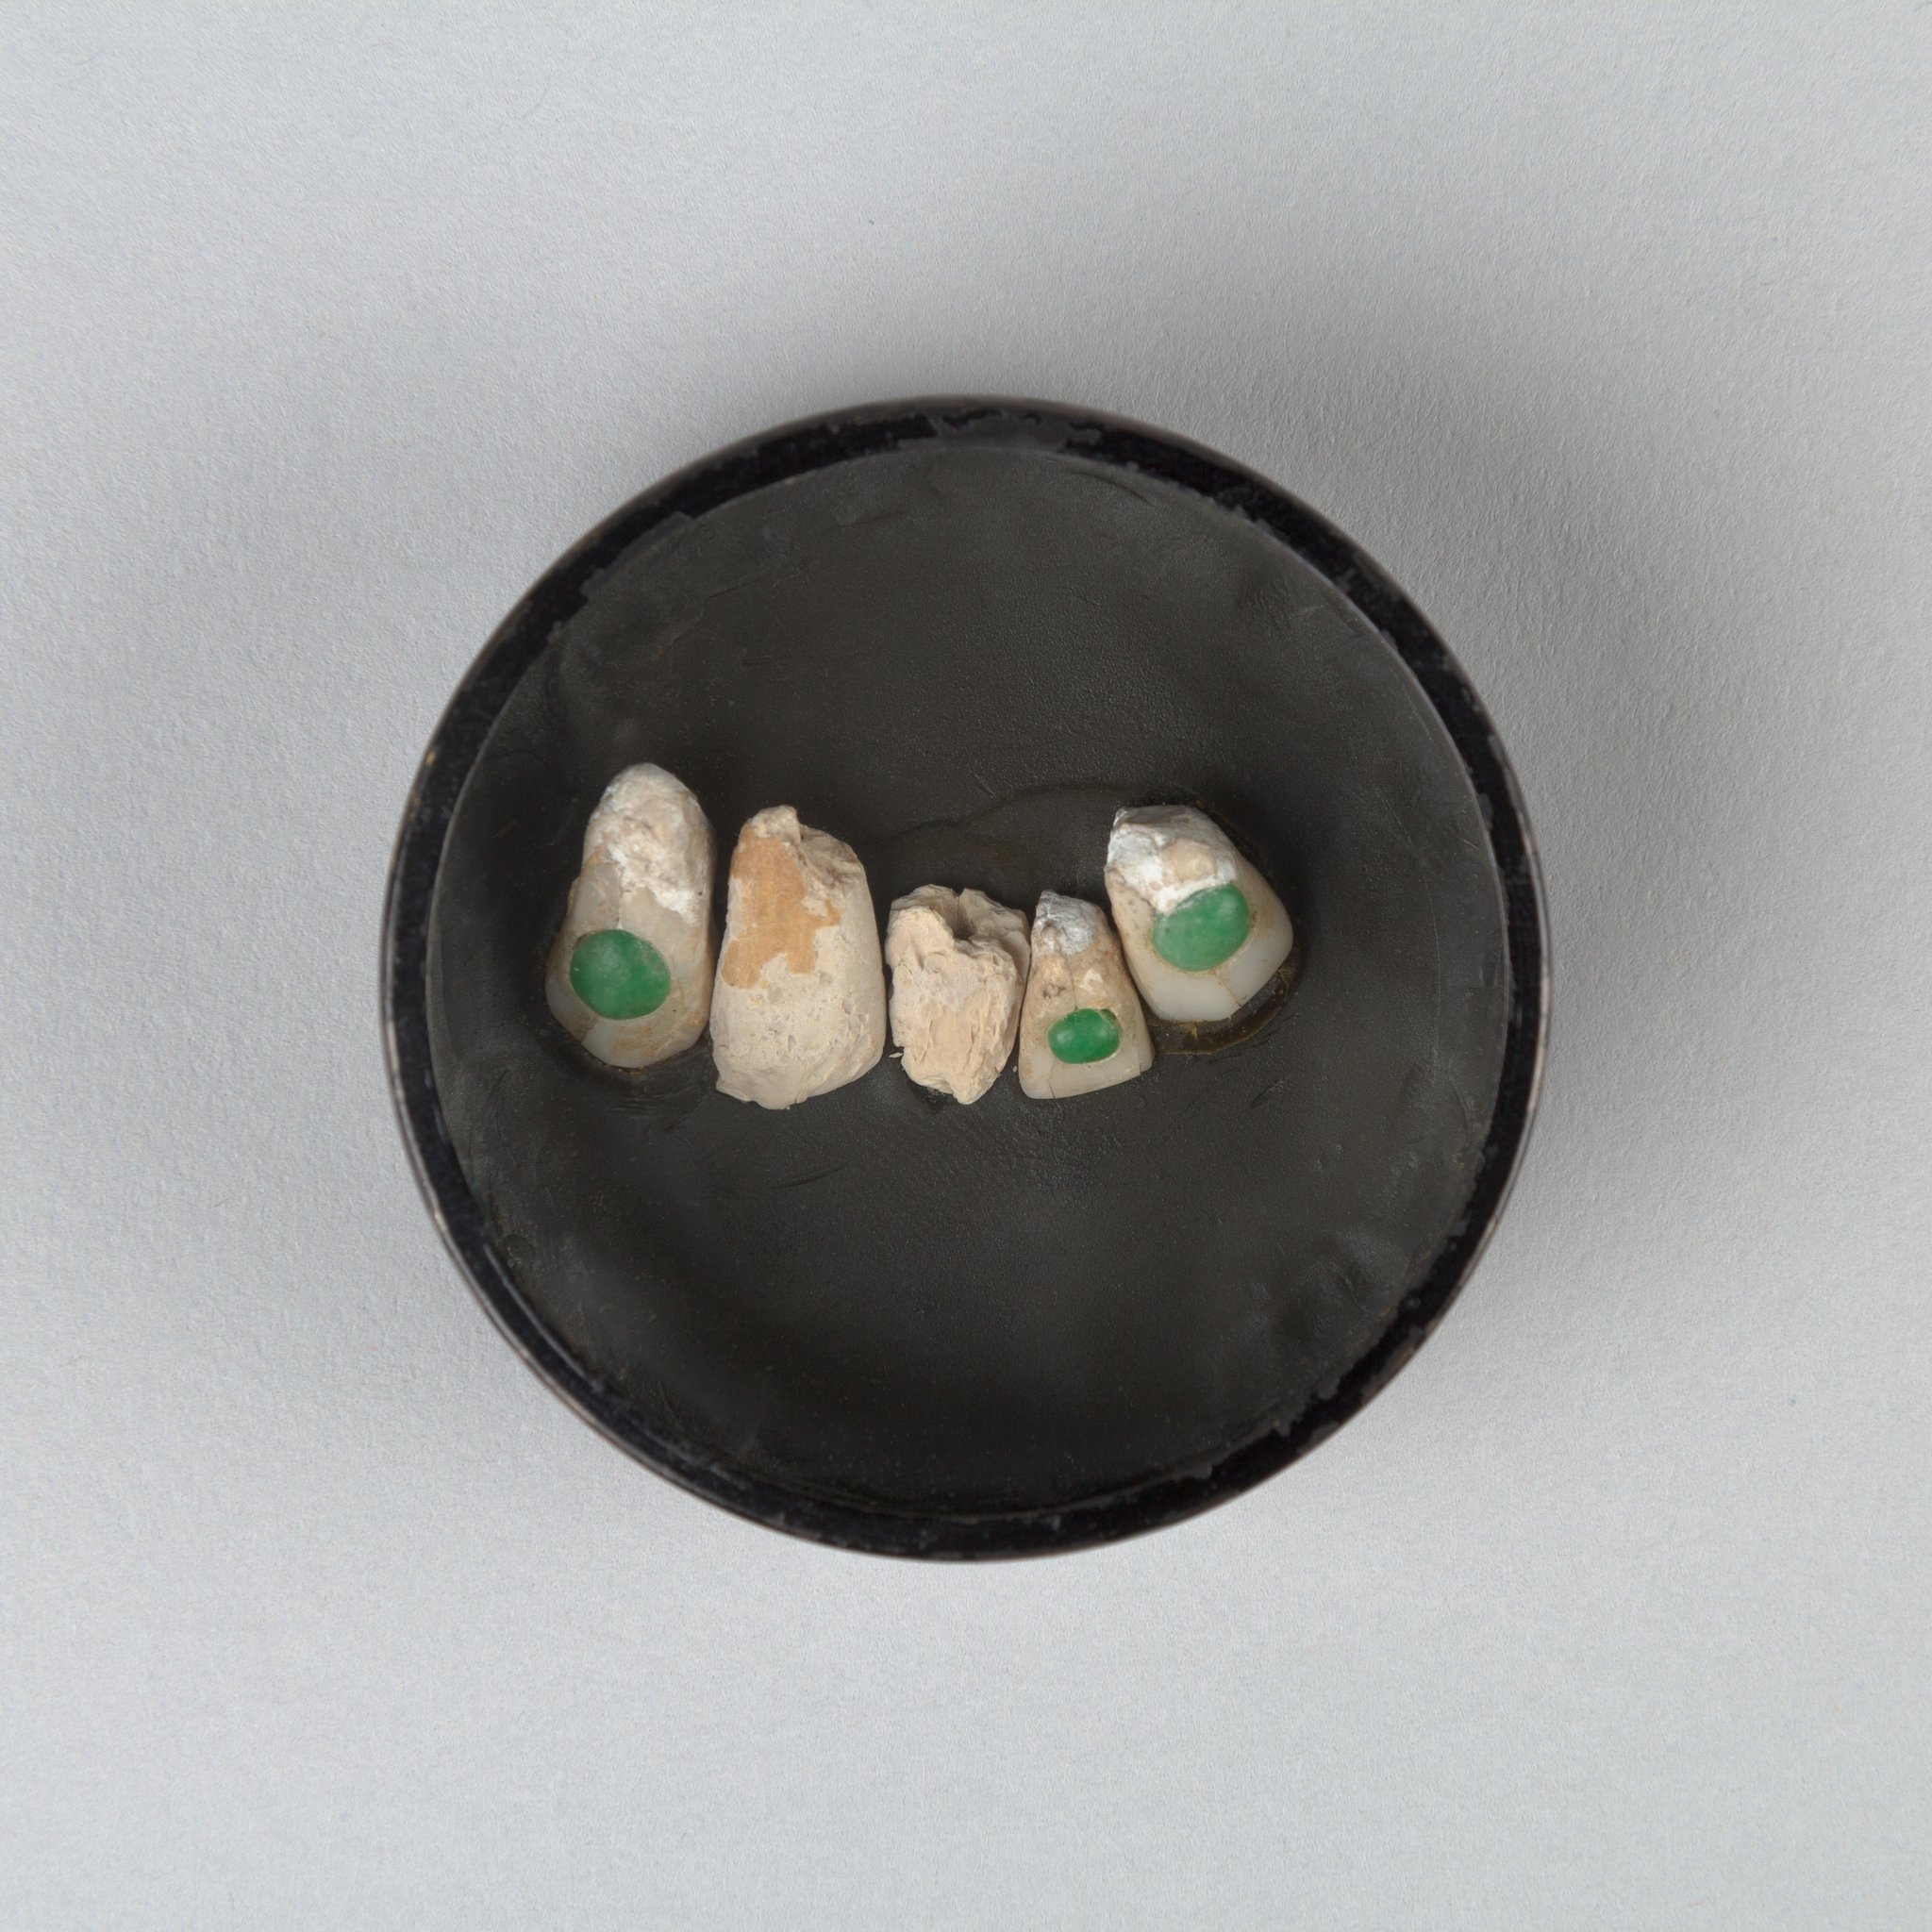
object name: human tooth inlaid with jadeite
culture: mexican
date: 1902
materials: jade